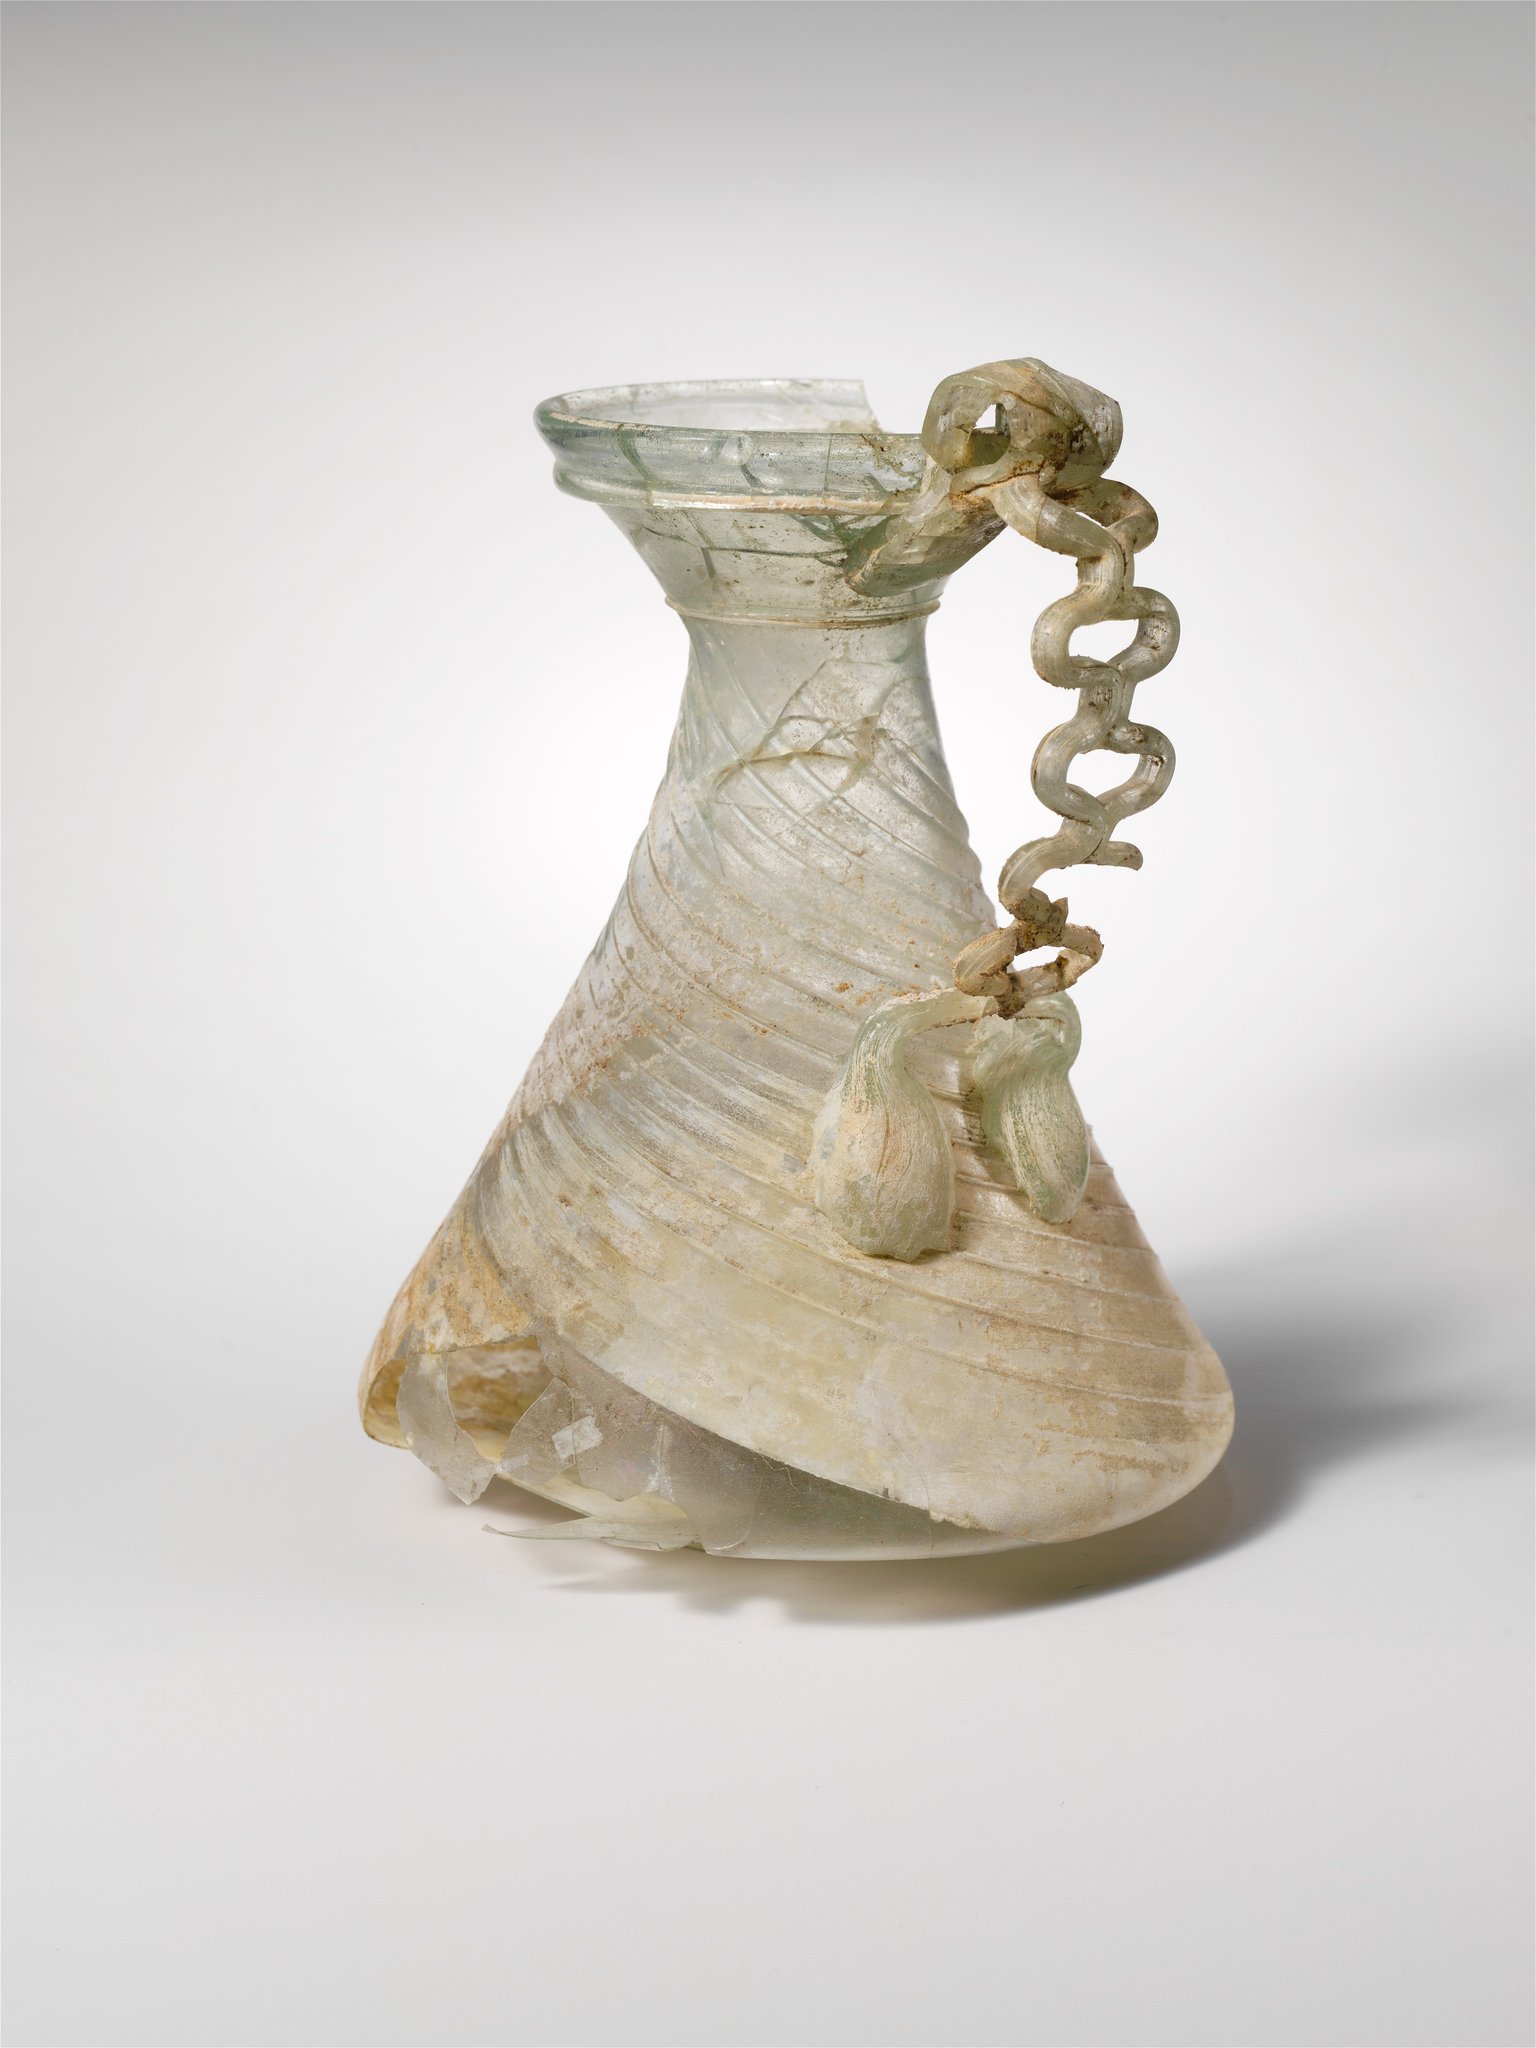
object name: jug with chain handle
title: Glass jug with chain handle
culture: roman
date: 201-333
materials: glass